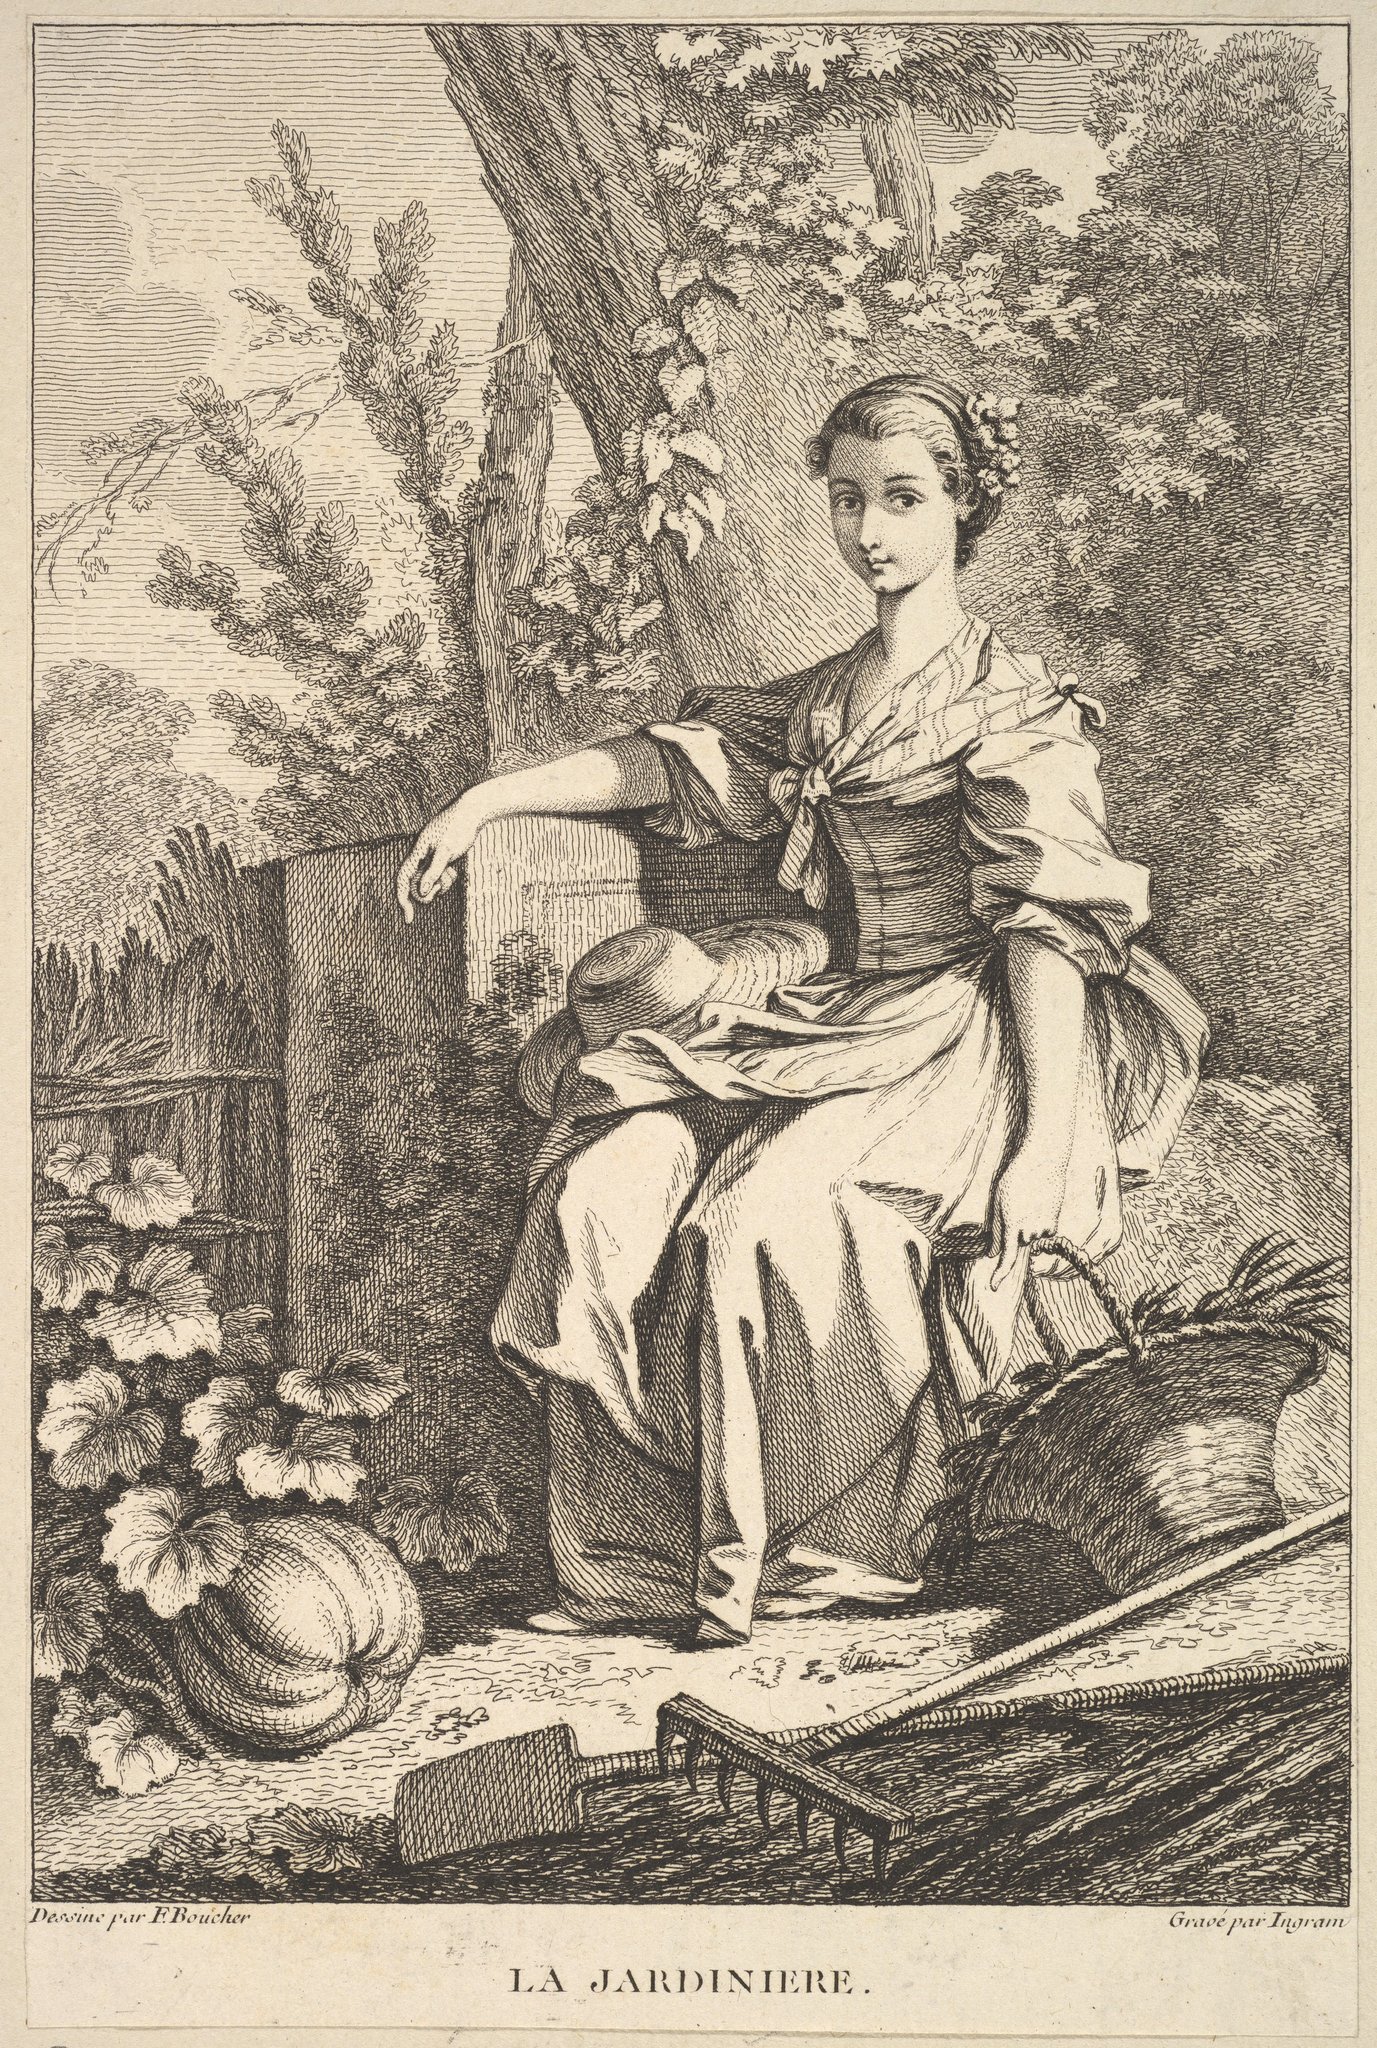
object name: print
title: The Gardener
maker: françois boucher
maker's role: artist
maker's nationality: french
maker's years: 1703-1770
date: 1741-1763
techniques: engraving, etching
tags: gardens,women,gardeners,tools